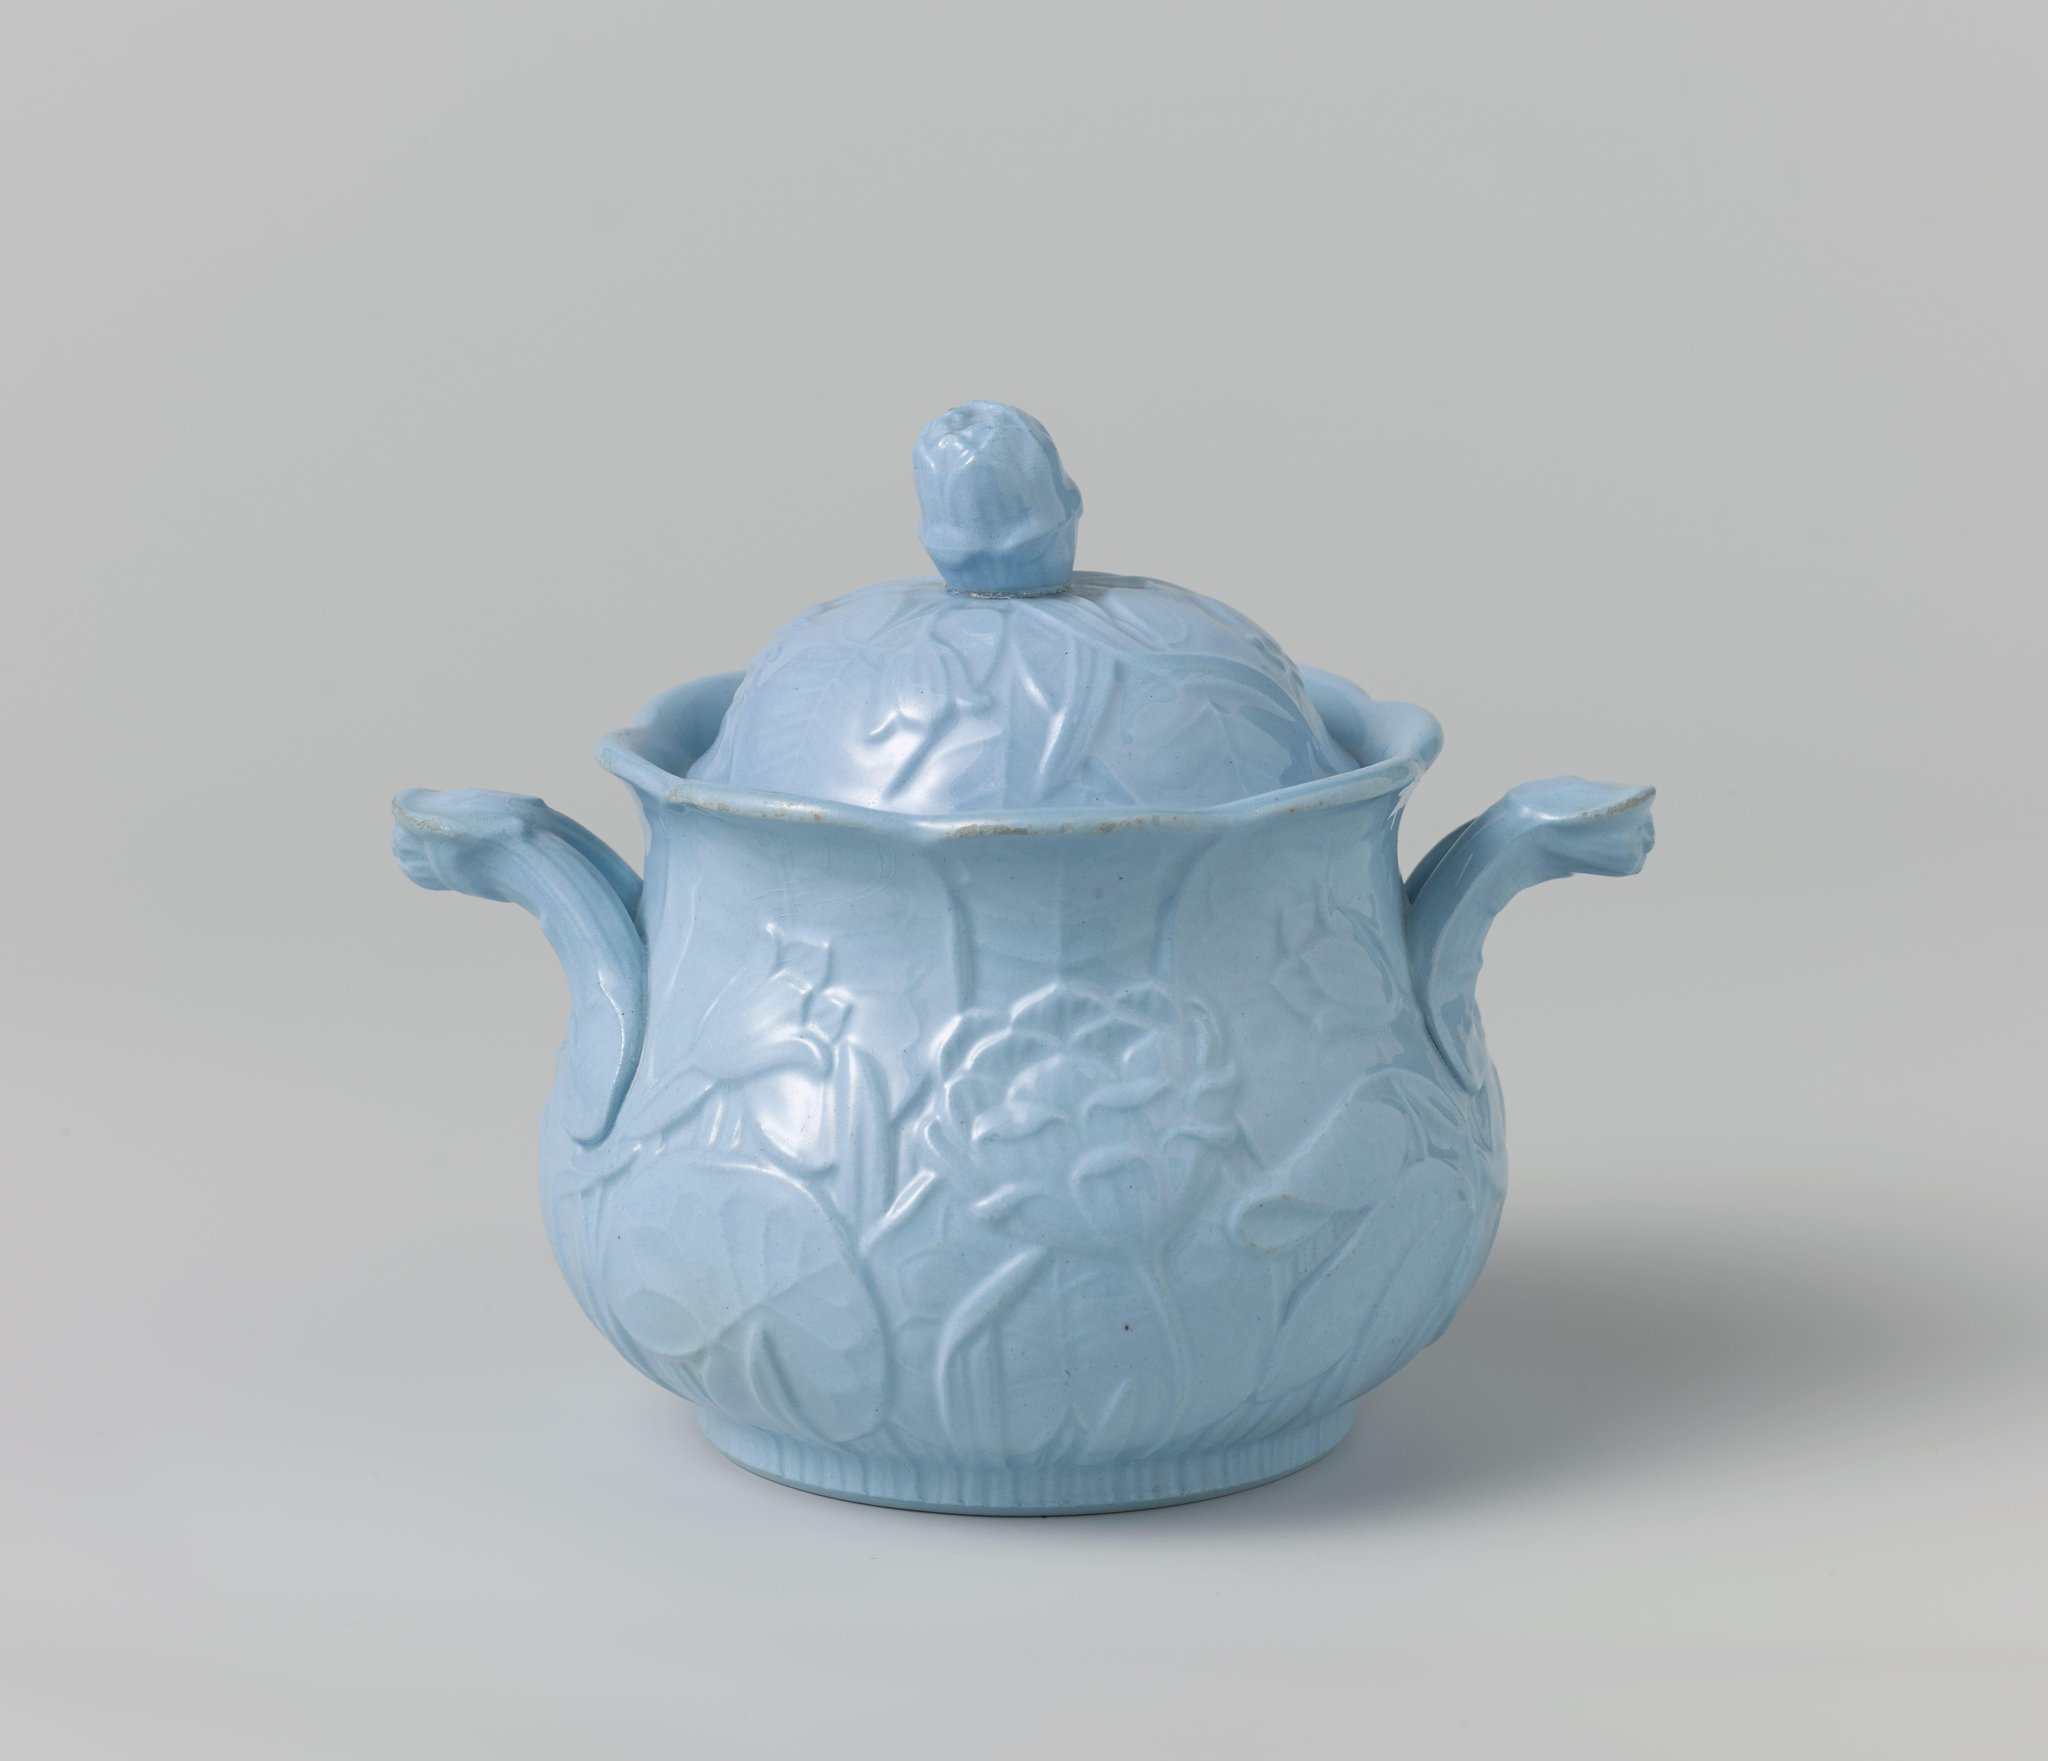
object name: sugar box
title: Suikerpot, blauw, met bladeren en bloemen in reliëf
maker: petrus regout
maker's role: plateelbakker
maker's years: 1801-1879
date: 1801-1879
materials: earthenware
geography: maastricht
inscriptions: check stamp: ‘P. REGOUT // MAASTRICHT // 00’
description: Suikerpot van blauwsteen, met in reliëf bladeren en bloemen over het gehele oppervlak. De bovenrand van de pot is geschulpt.